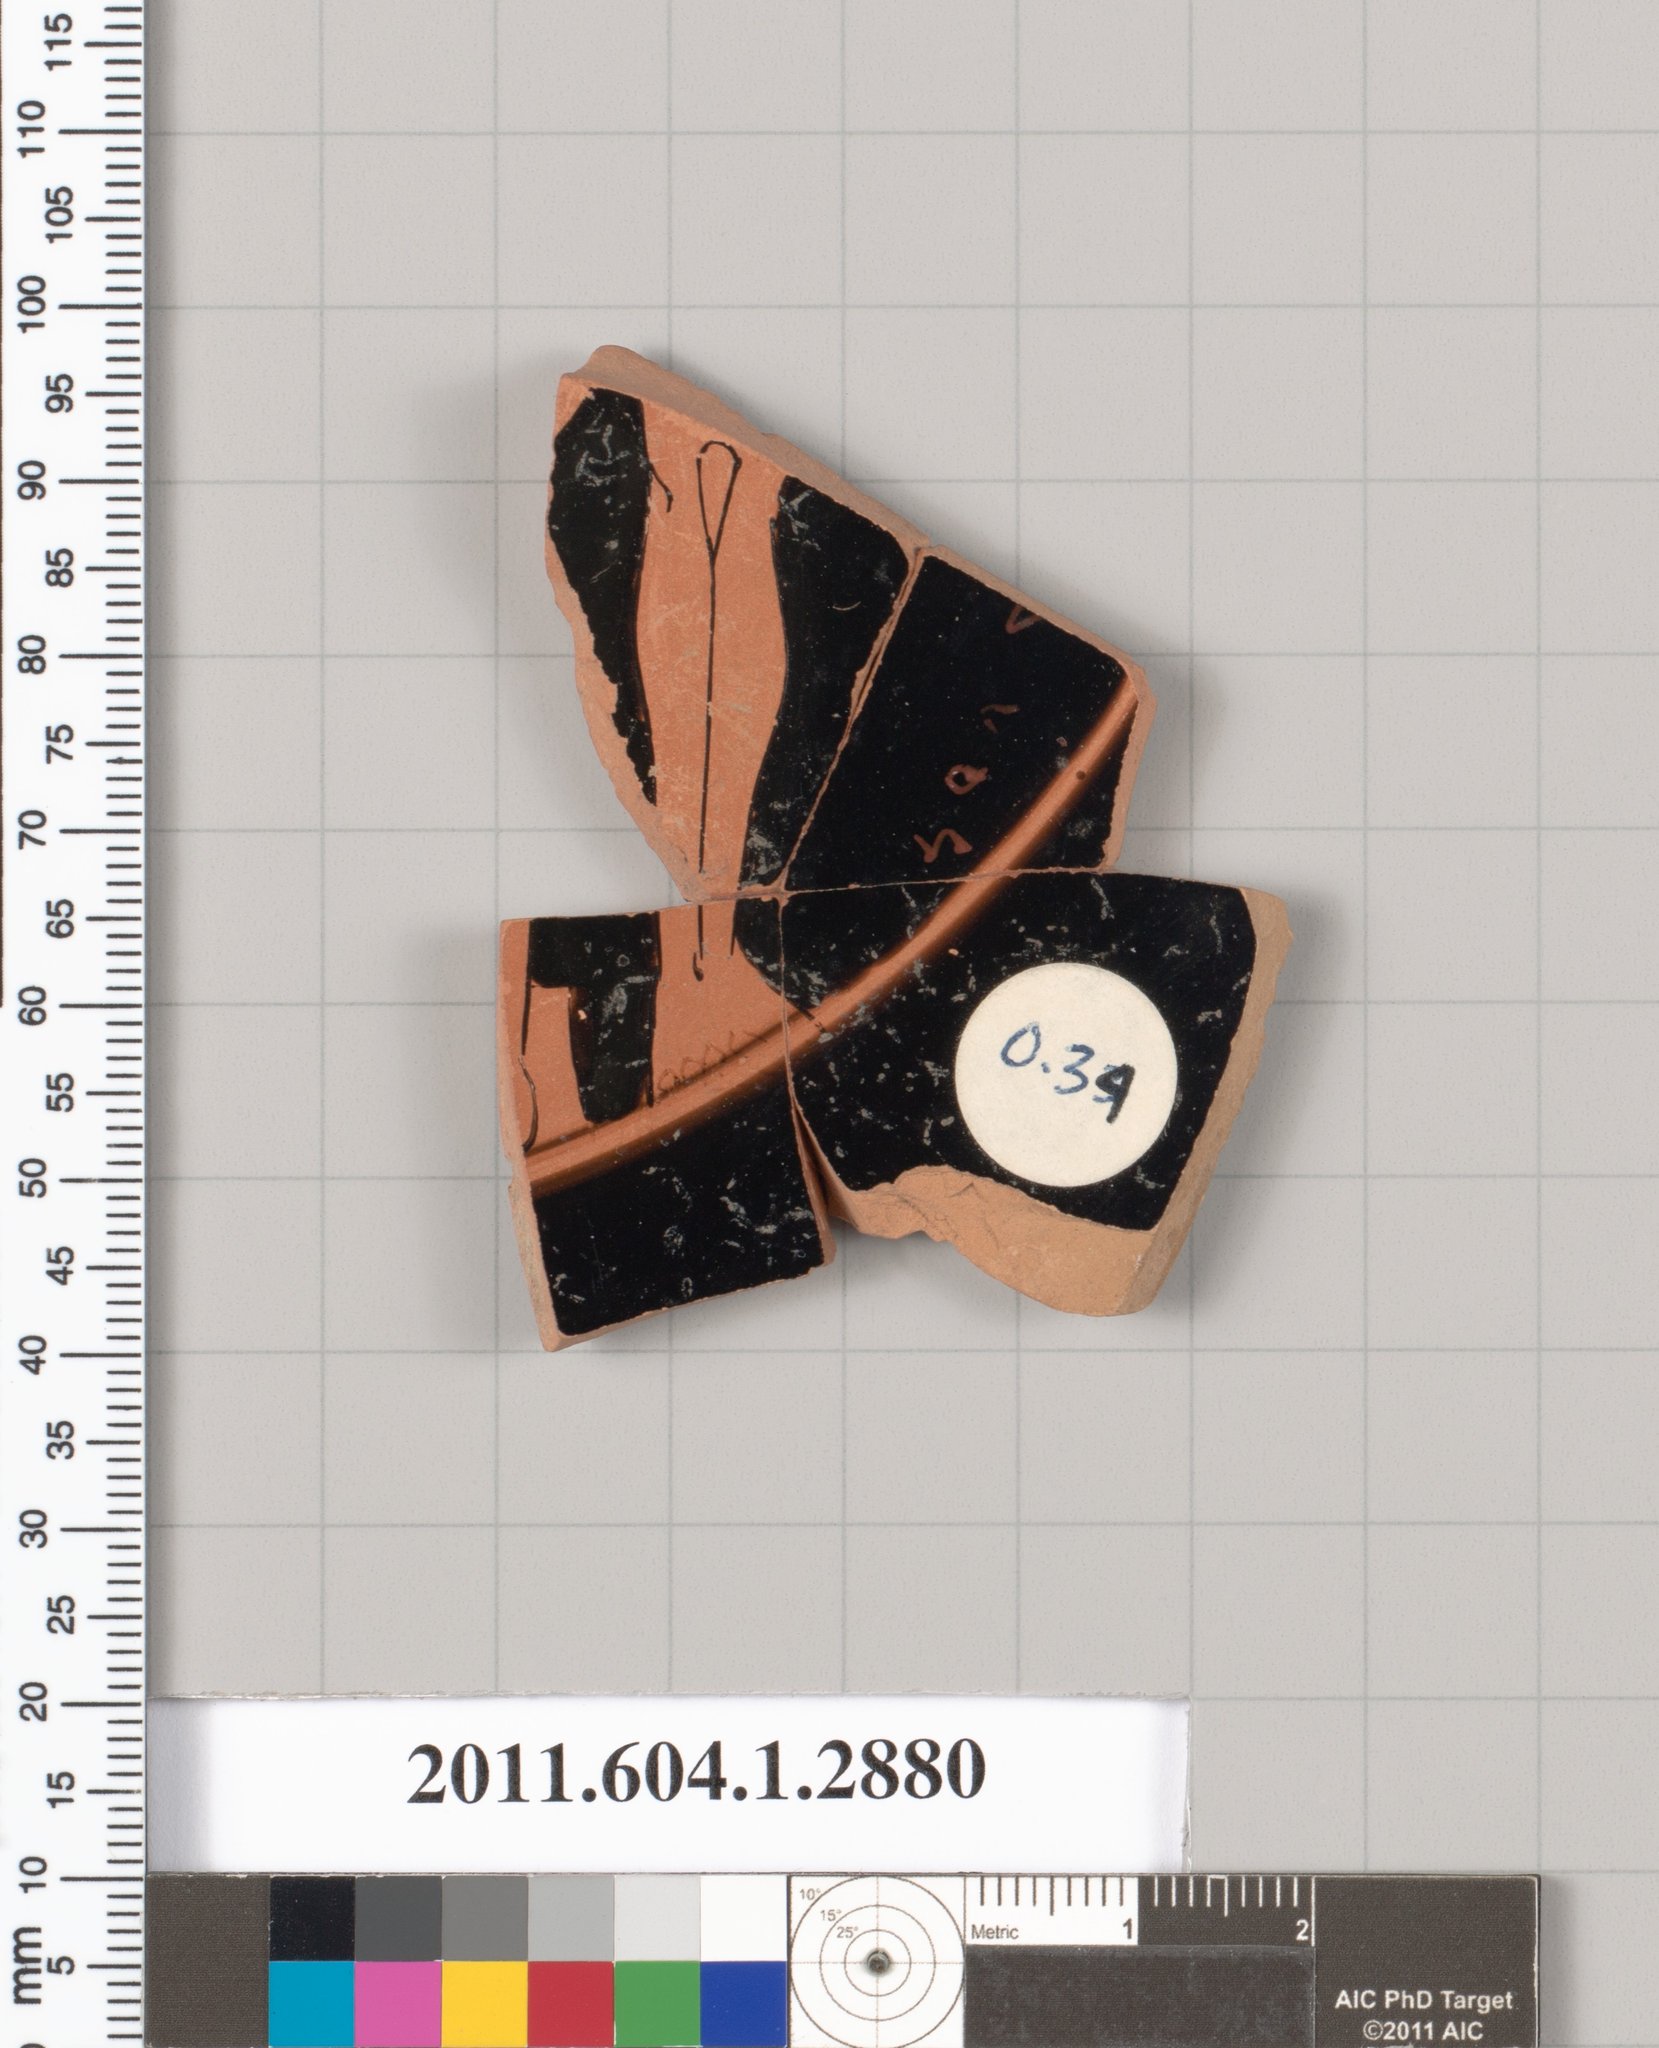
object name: kylix fragment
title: Terracotta fragment of a kylix (drinking cup)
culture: greek, attic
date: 500-480 BCE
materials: terracotta